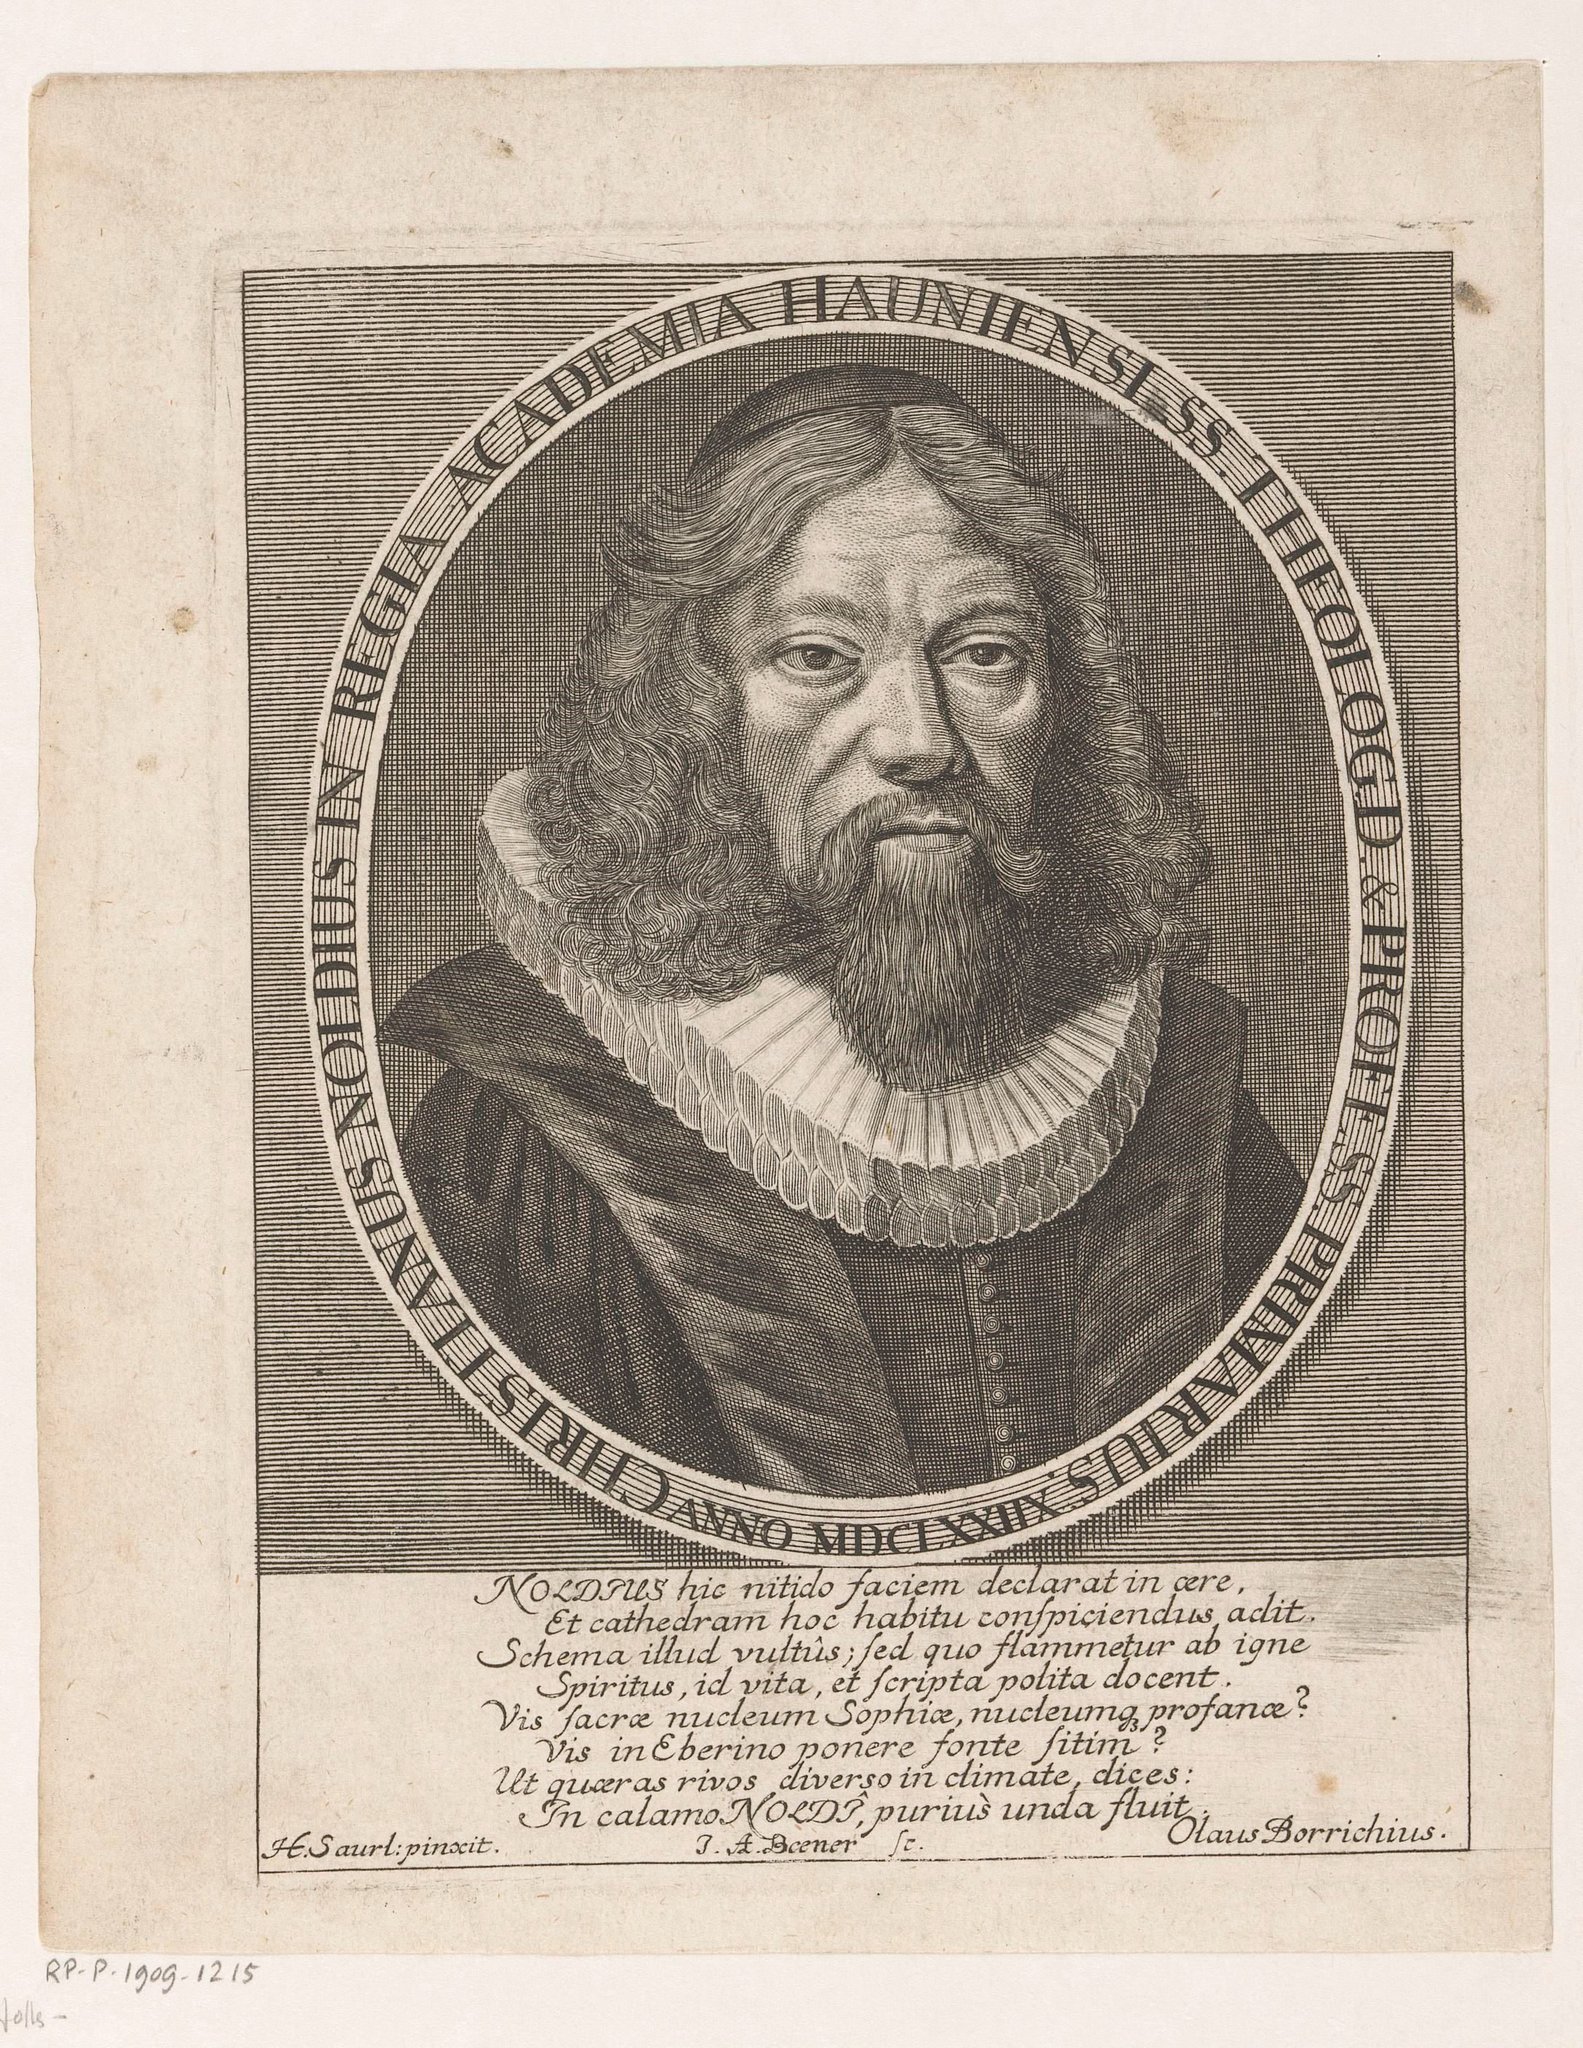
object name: print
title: Portret van Christianus Nold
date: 1678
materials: paper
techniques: engraving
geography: copenhagen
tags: copenhagen (city), historical persons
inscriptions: collector's mark: Lugt 2228